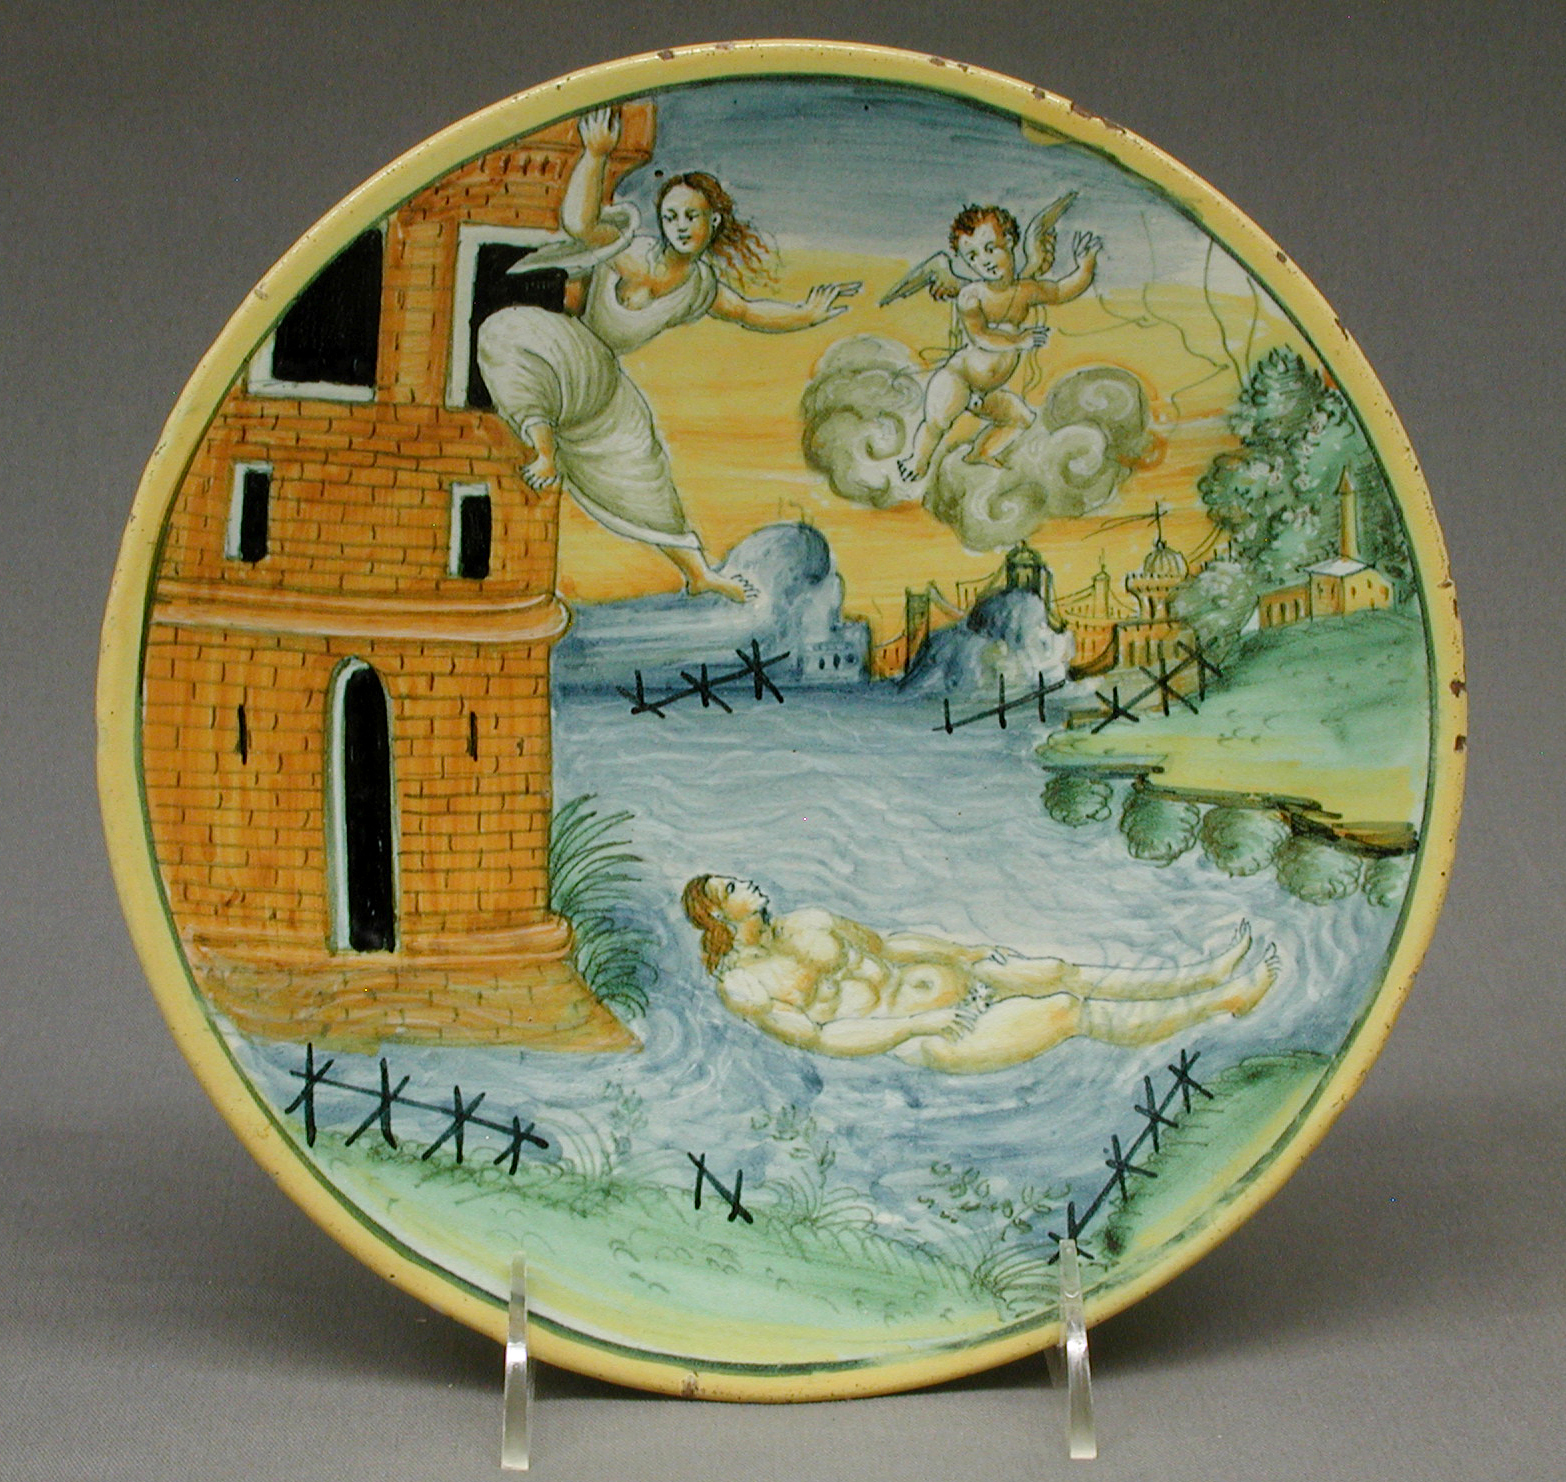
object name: dish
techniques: maiolica, glazing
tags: male nudes,women,rivers